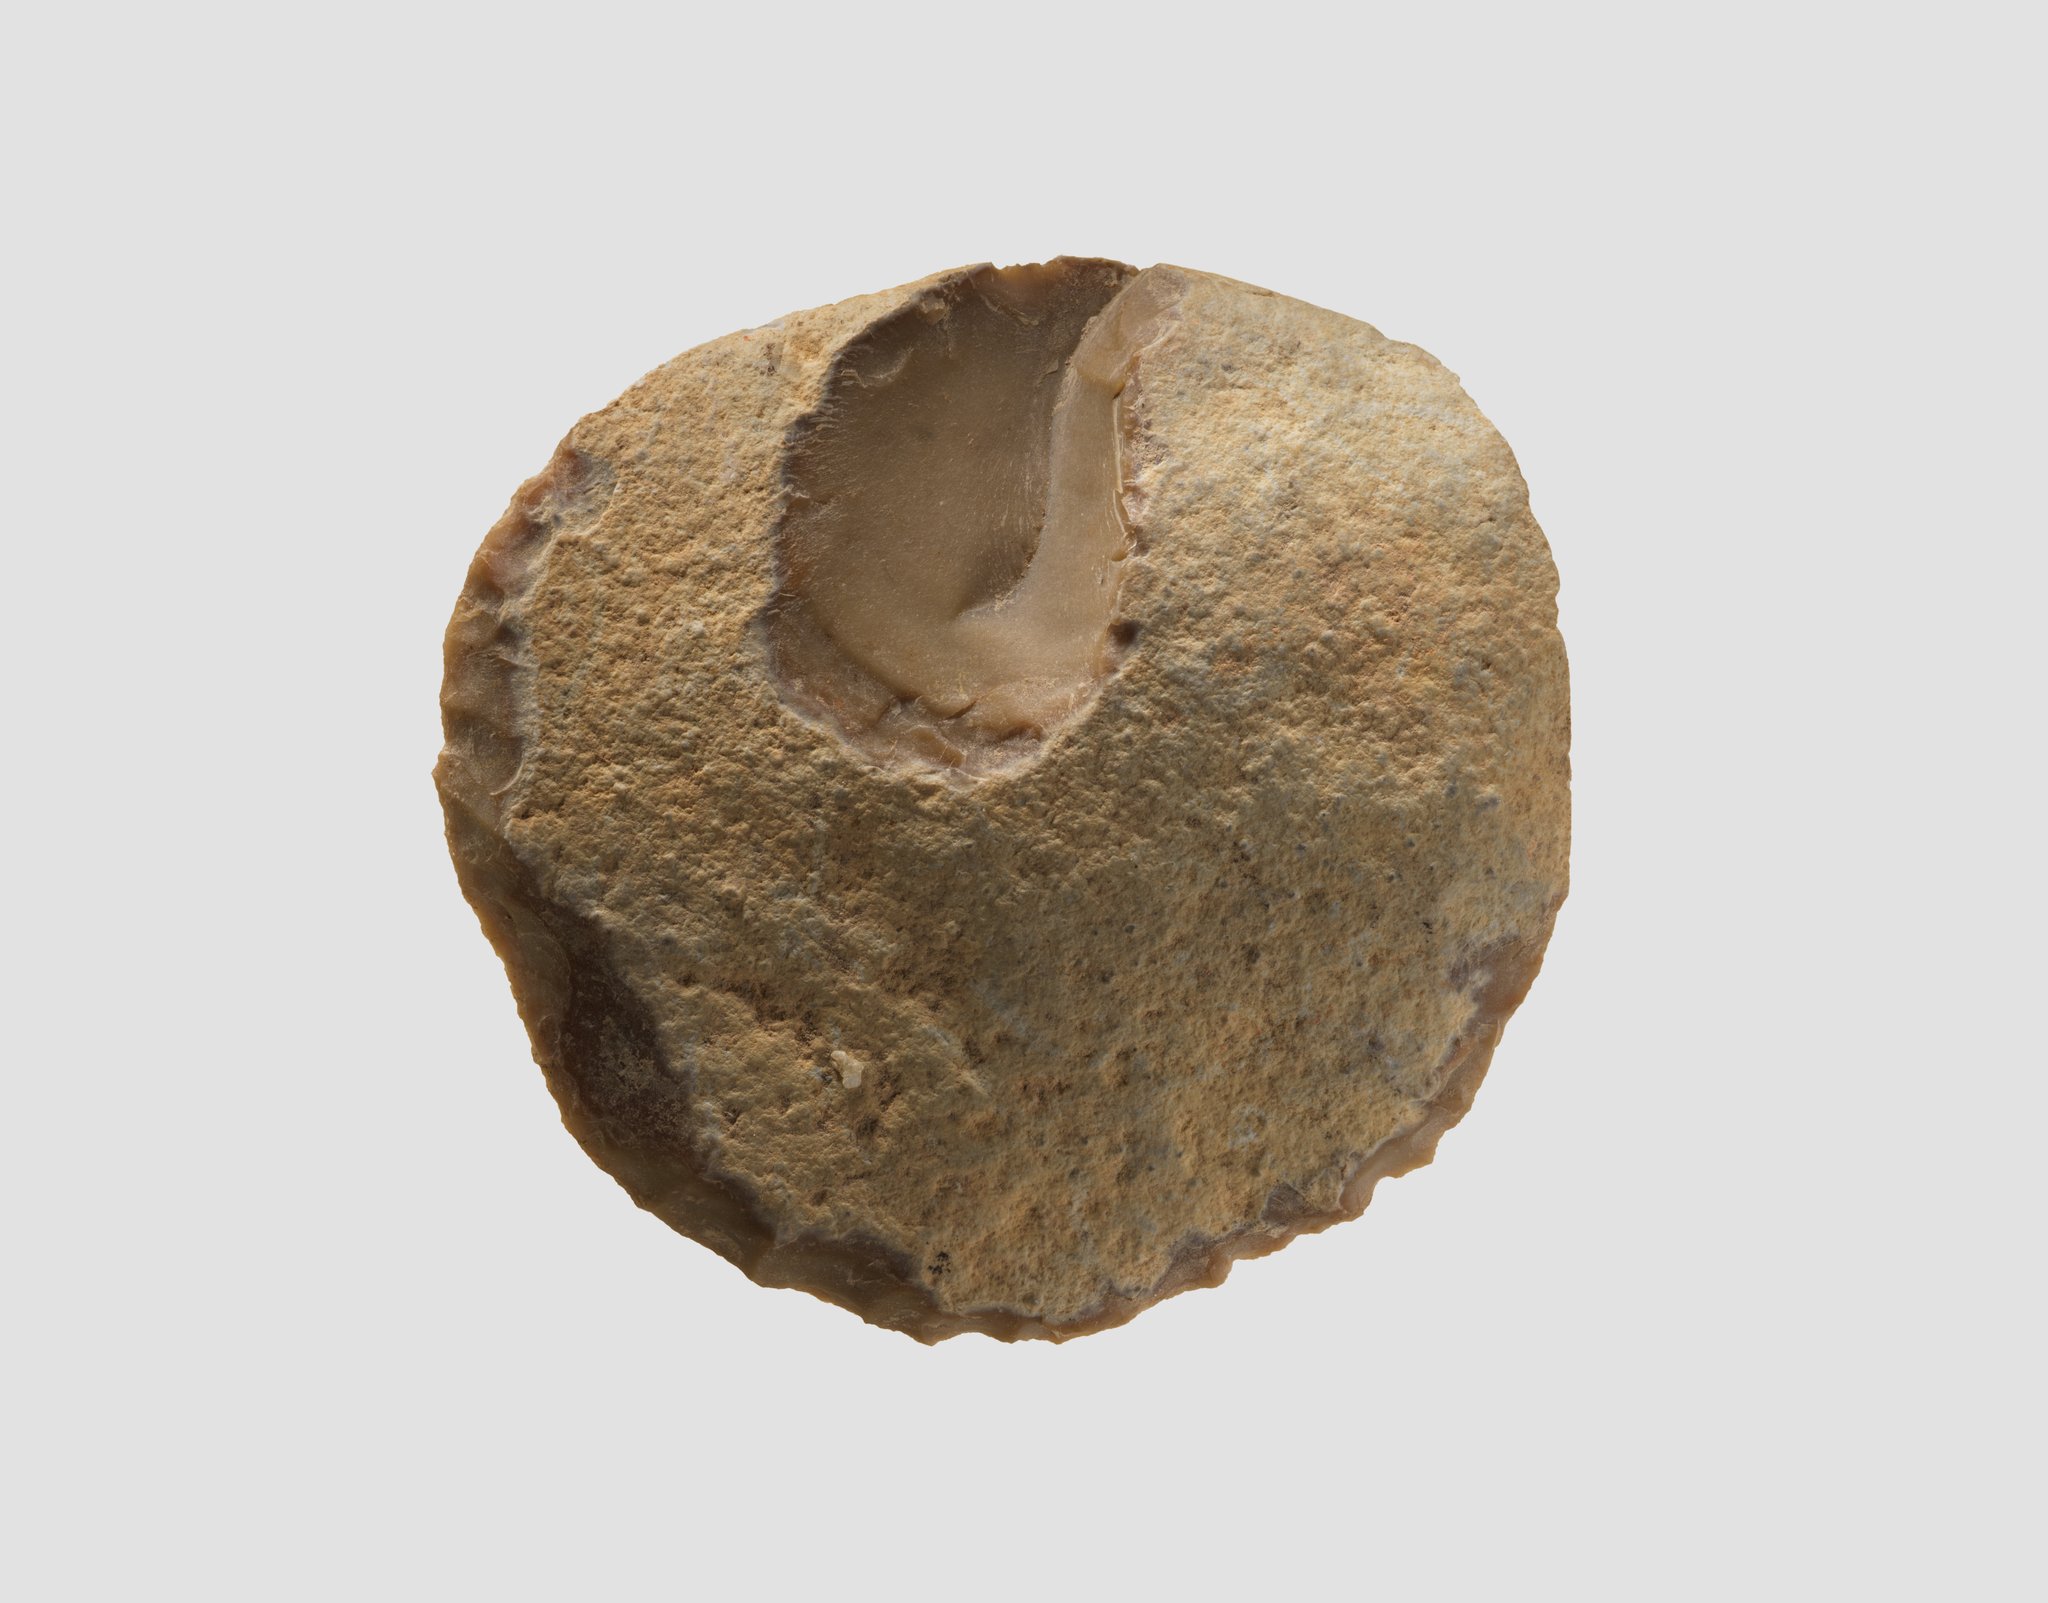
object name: scraper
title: Fan scraper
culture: ghassulian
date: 4600-3600 BCE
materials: stone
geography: levant